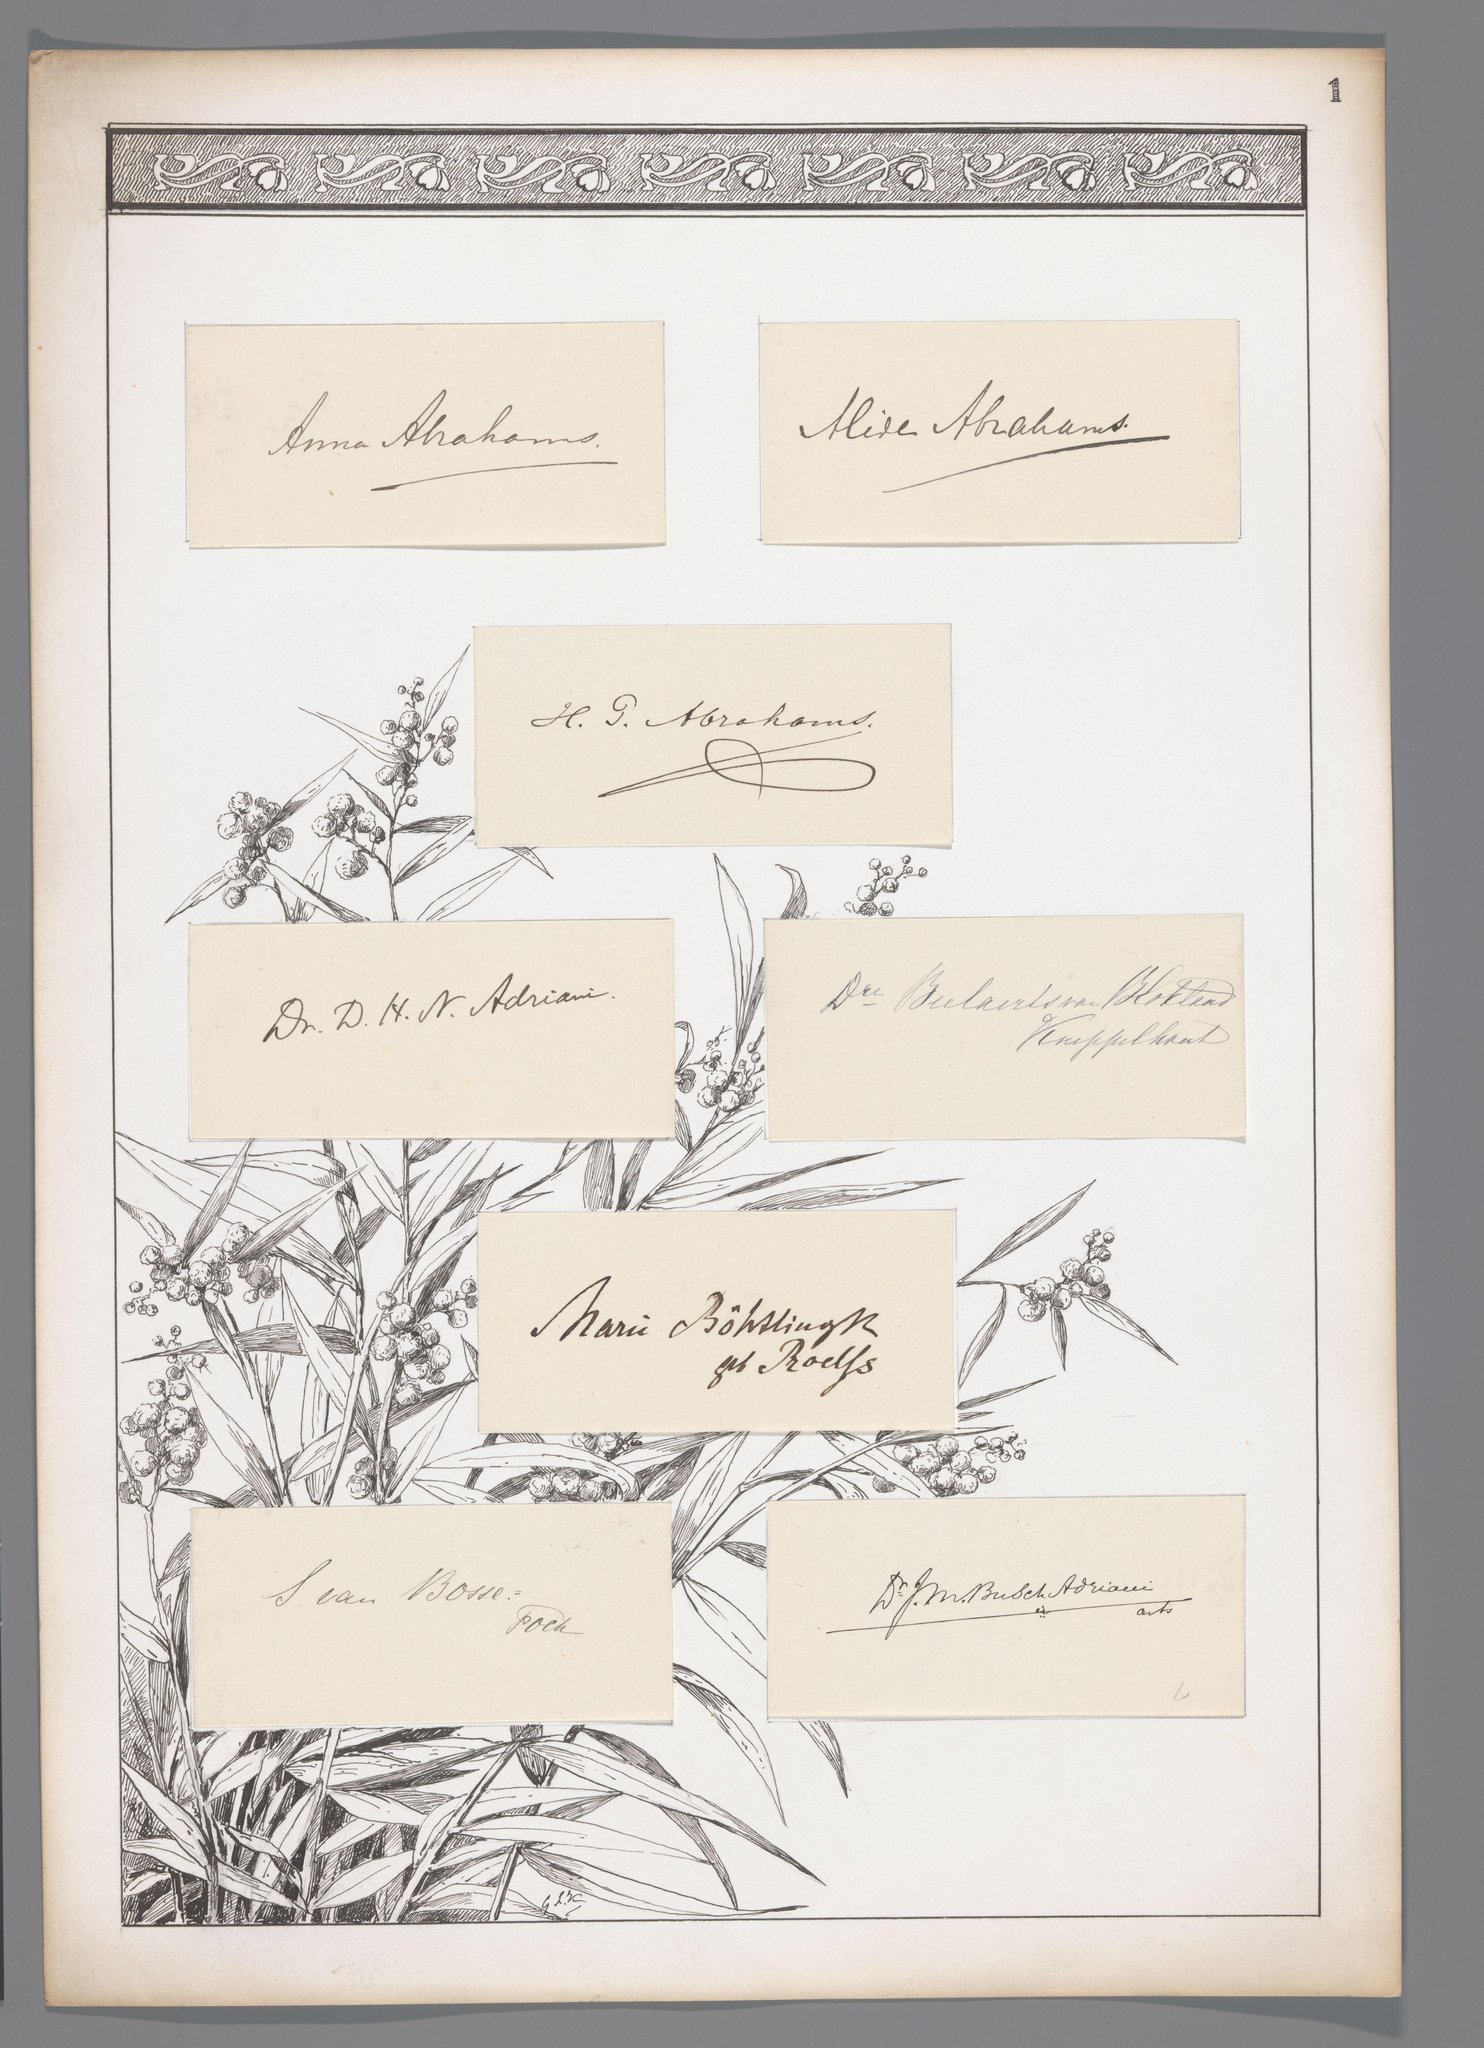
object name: drawing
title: Acht handtekeningen geplakt op een blad met een plant en decoratieve rand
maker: george lourens kiers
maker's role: draughtsman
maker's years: 1838-1916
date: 1904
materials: ink, paper, pencil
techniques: pen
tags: painter, anna abrahams, middelburg, the hague, hendrik paulus abrahams, plants and herbs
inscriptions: number: ‘I’